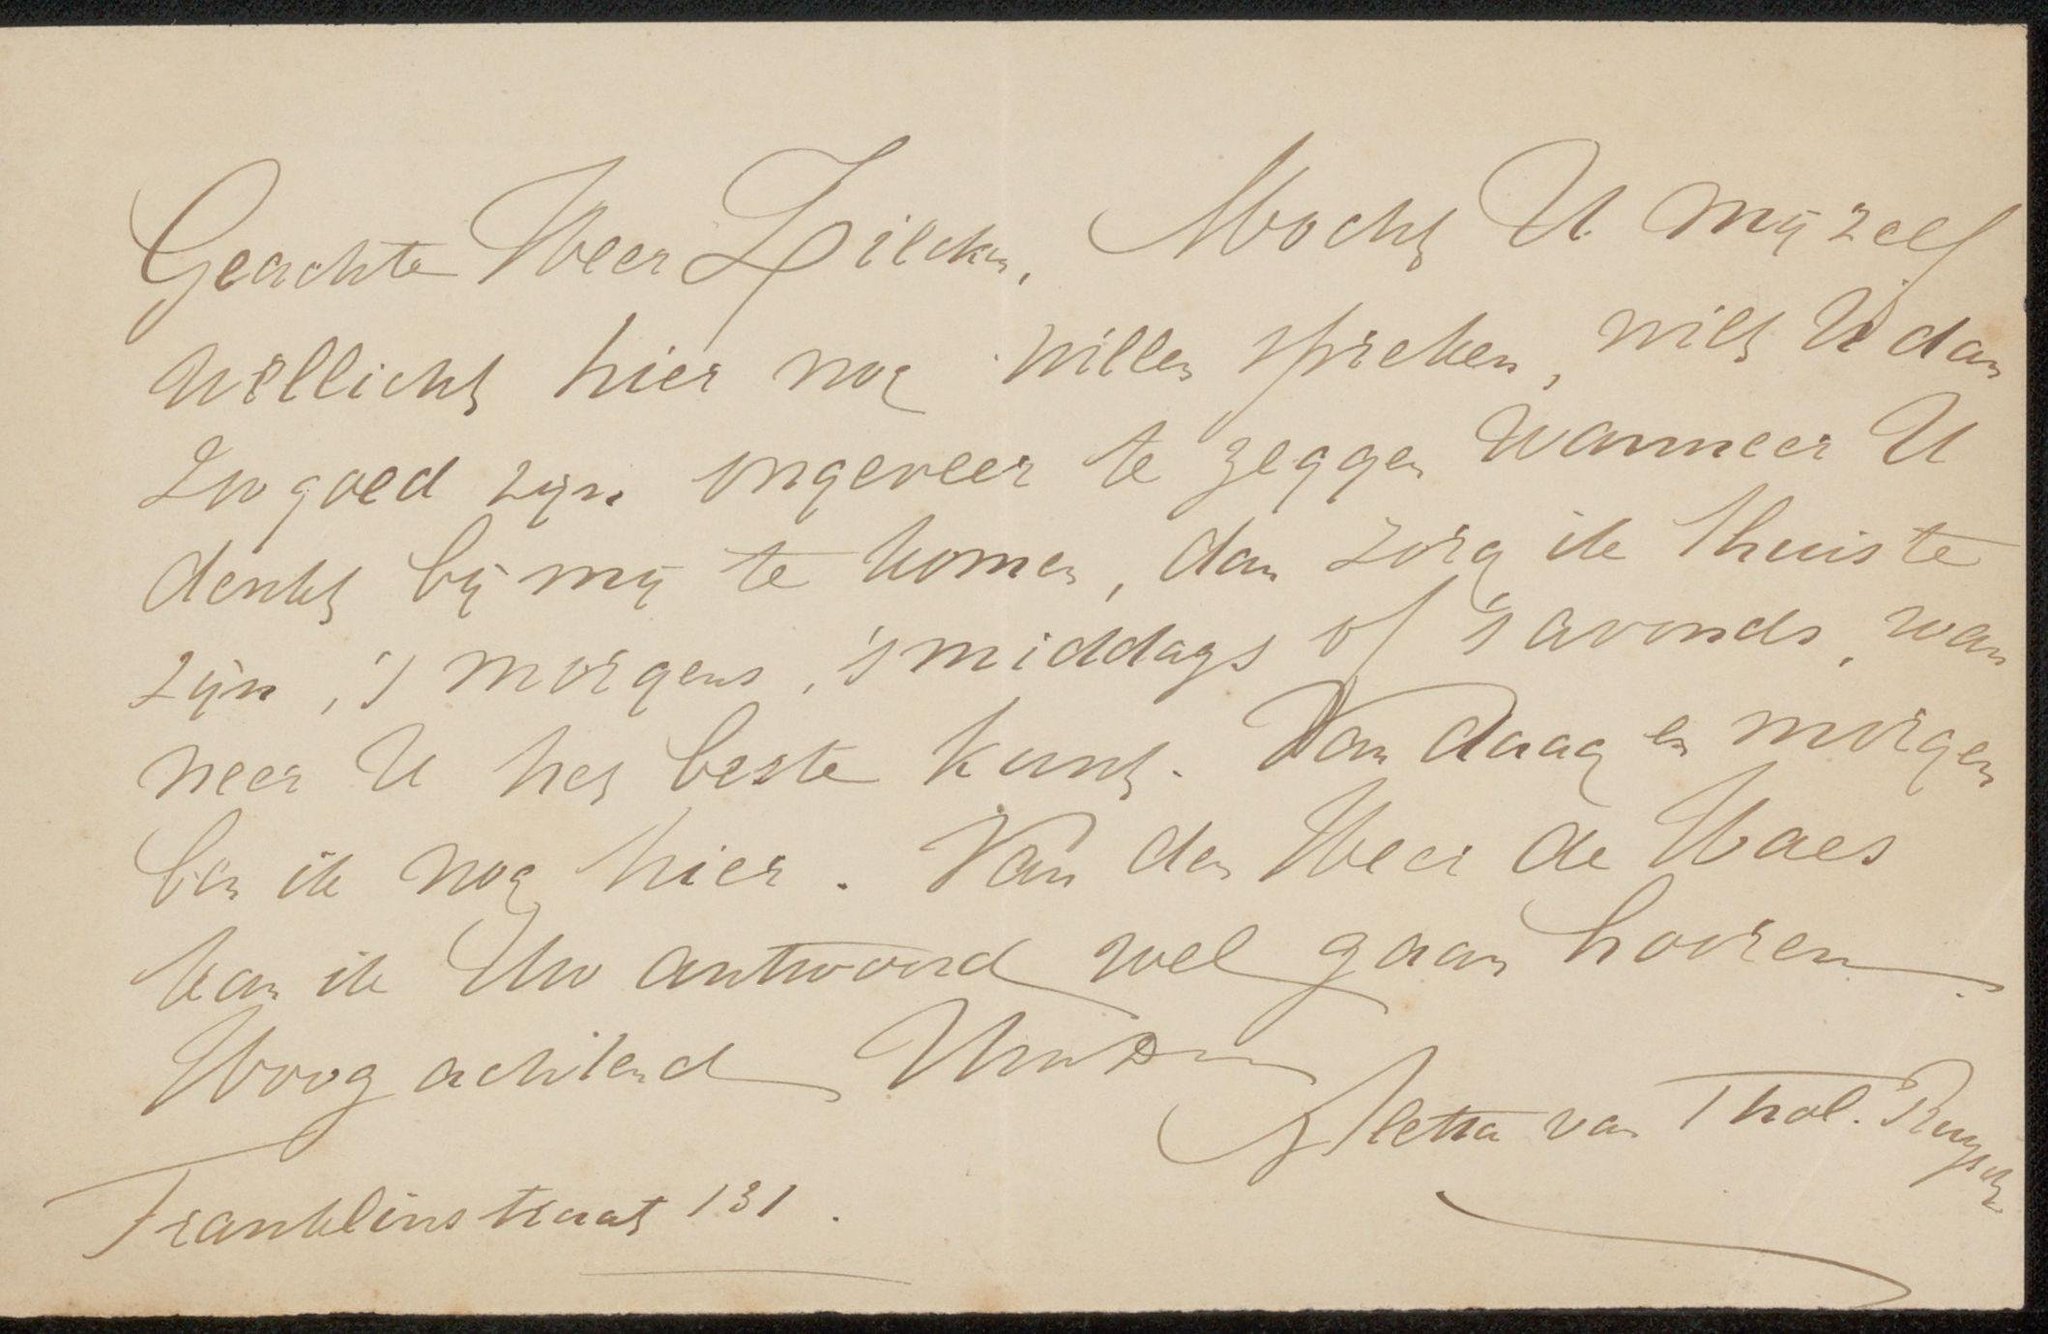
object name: letter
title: Brief aan Philip Zicken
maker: aletta ruijsch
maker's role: draughtsman, painter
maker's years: 1860-1930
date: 1867-1930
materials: ink, paper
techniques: pen, writing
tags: philip zilcken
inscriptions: collector's mark: ‘RPK’